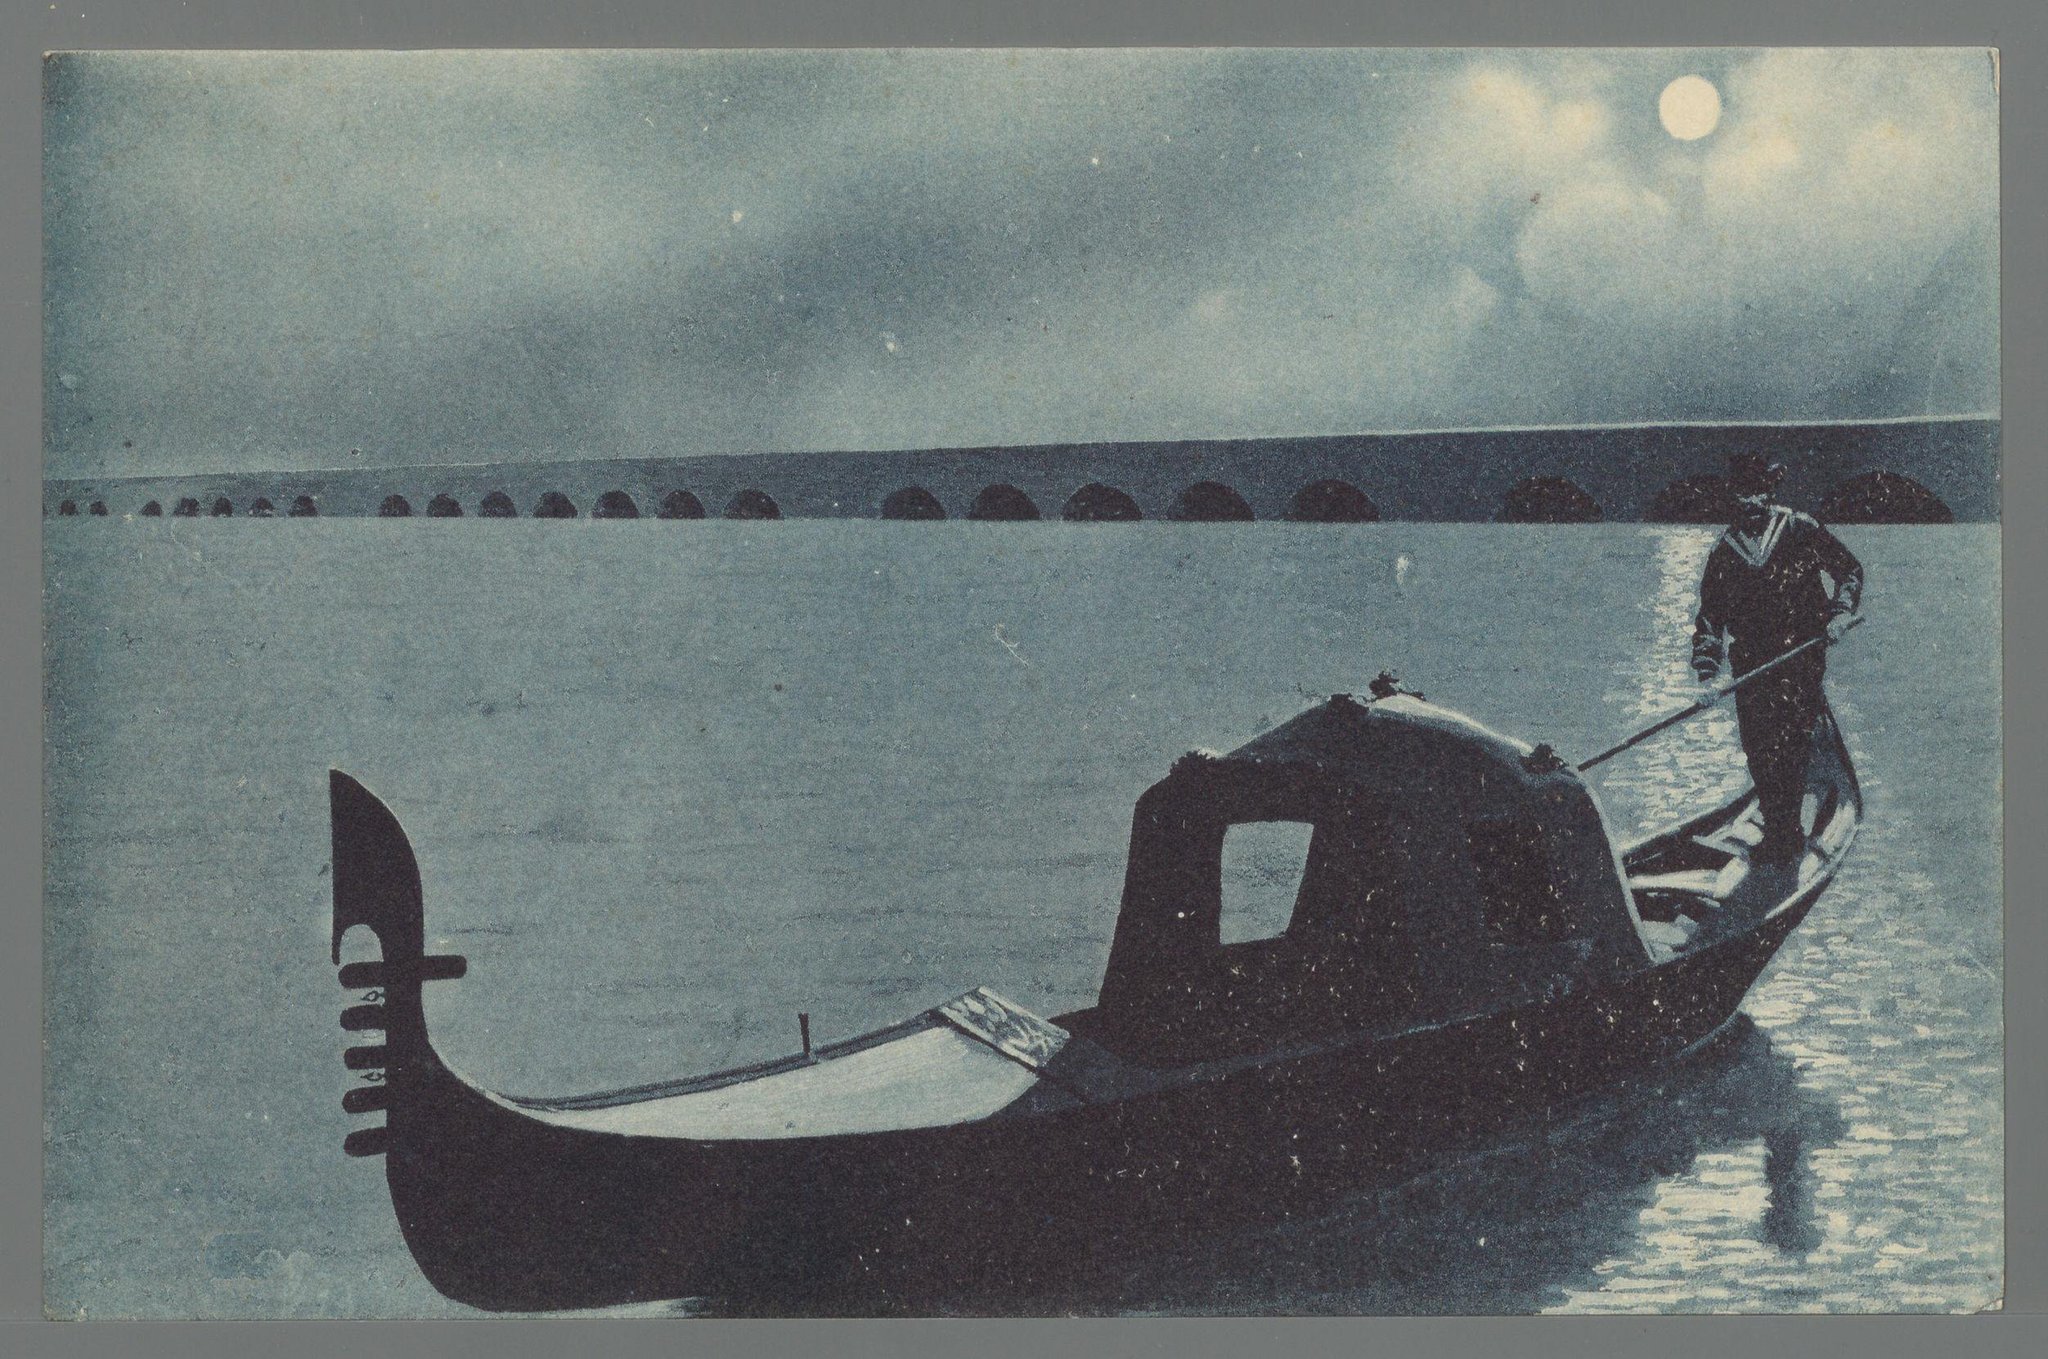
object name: ansichtkaart, prentbriefkaart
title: Venezia. Gondola e Ponte della Ferrovia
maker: Anonymous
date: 1900-1905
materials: cardboard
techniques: photograph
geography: venice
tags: moonlight, railway, train, gondola, venice